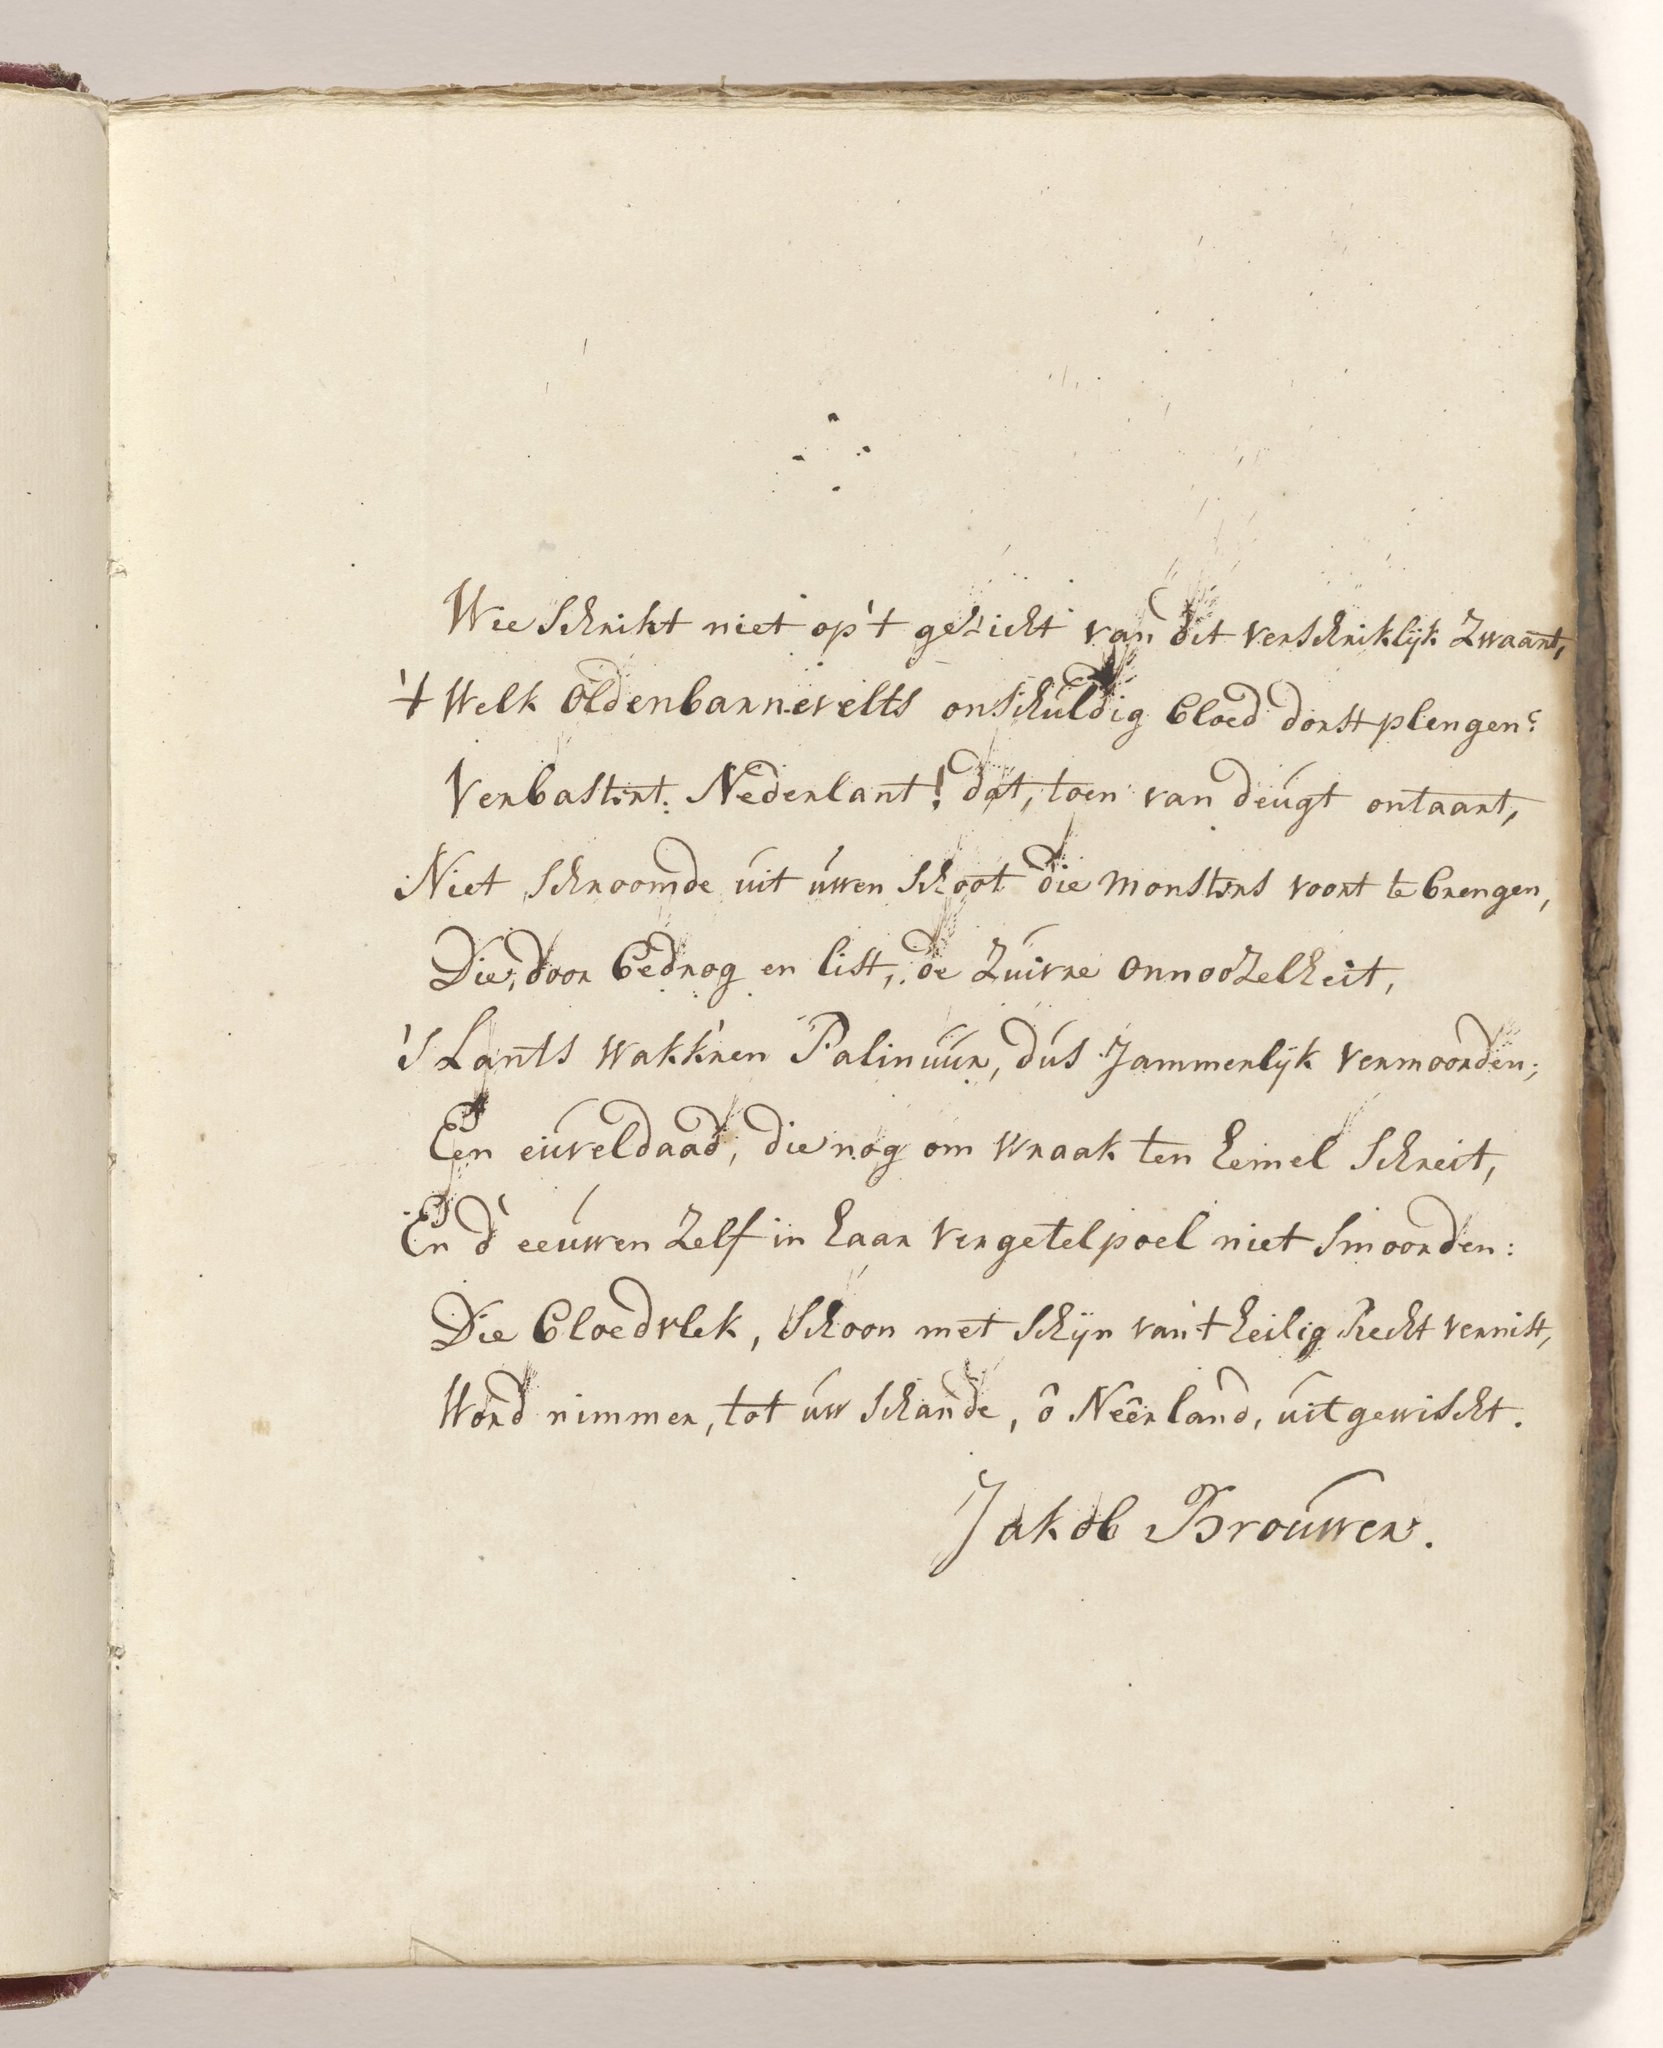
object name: manuscript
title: Gedicht op het zwaard waarmee Johan van Oldenbarnevelt in 1619 zou zijn onthoofd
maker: jakob brouwer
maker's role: dichter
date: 1743-1745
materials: ink, paper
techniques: writing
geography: netherlands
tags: johan van oldenbarnevelt, rotterdam, dordrecht, print maker, frans greenwood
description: Vers van Jakob Brouwer. Onderdeel van het boek met gedichten uit de jaren 1743-1745 op het zwaard waarmee Johan van Oldenbarnevelt in 1619 zou zijn onthoofd. Het zwaard was eigendom van Frans Greenwood.